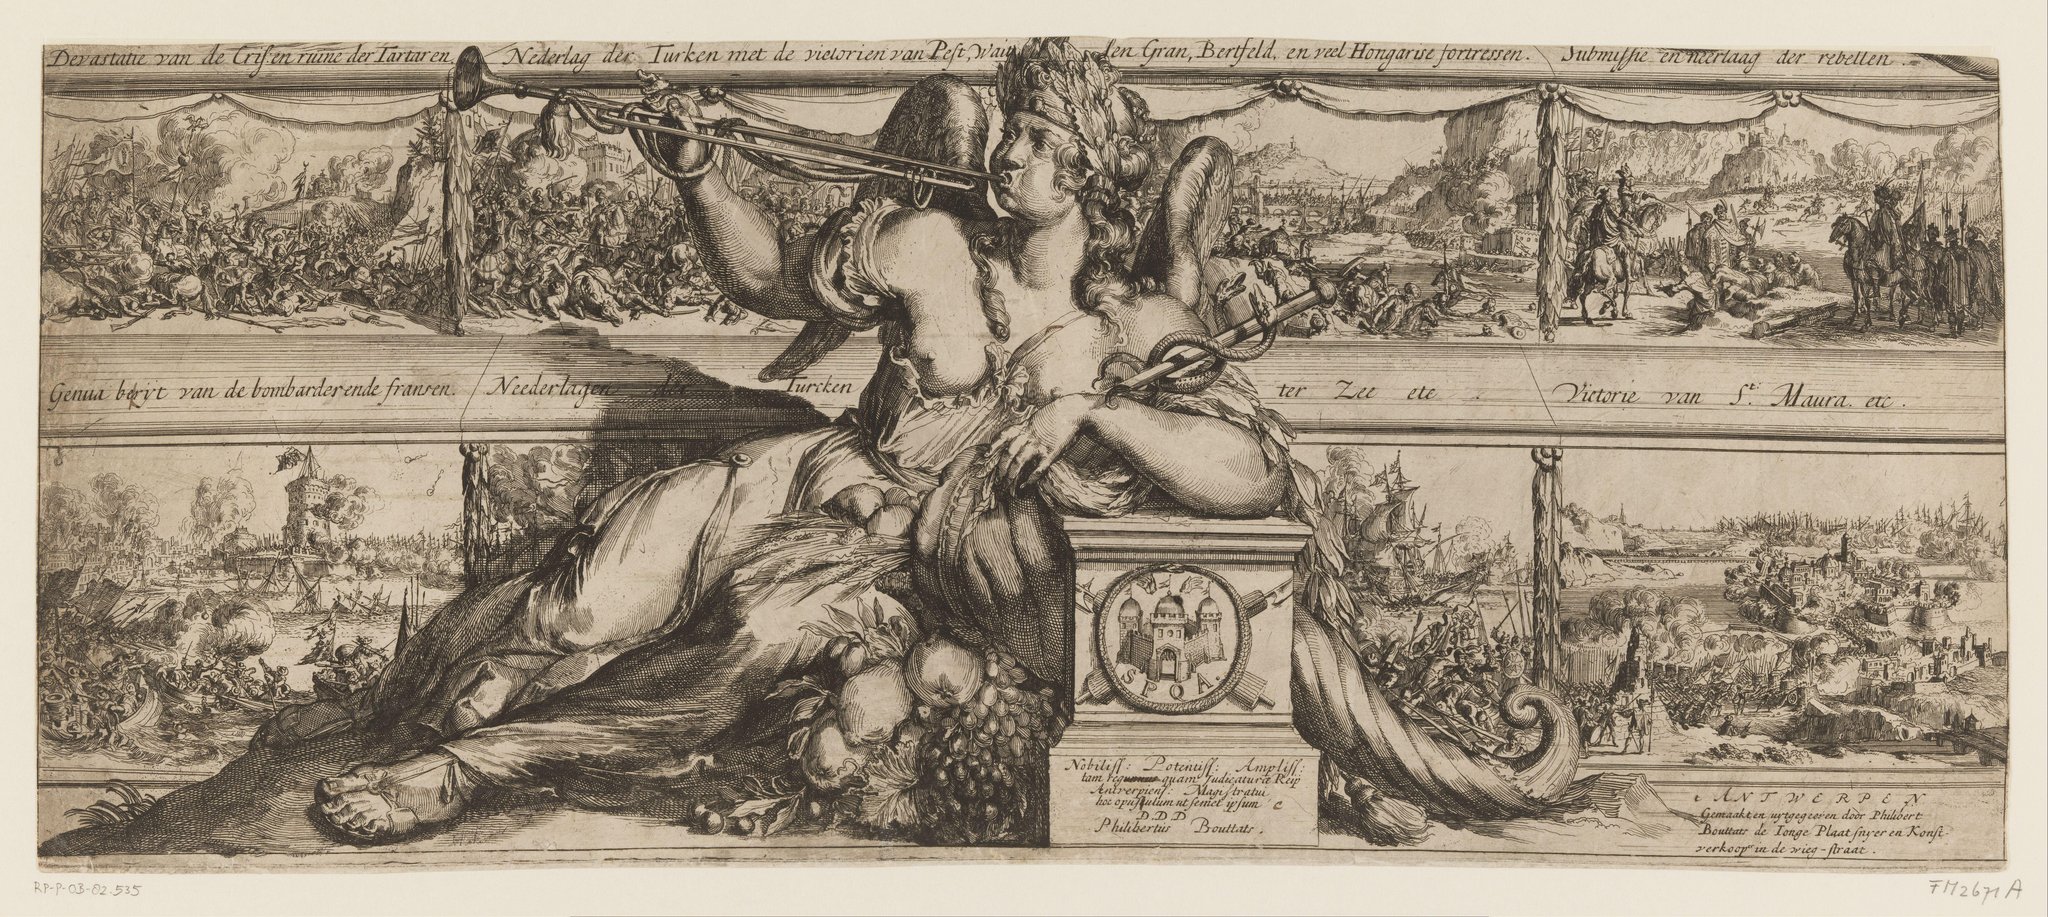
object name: print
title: Allegorie op de overwinningen op de Turken, 1685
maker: philibert bouttats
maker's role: print maker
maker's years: 1635-1708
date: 1685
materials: paper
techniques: etching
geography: antwerp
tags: fame; 'fama', 'fama buona', 'fama chiara' (ripa), battle (+ land forces)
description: Deze prent hier in de eerste staat met volledige figuur van de Faam en met naam en adres Philibert Bouttats. In een latere staat (zie de afbeelding in het artikel in Oud-Holland) is de plaat afgesneden waardoor alleen een buste van de Faam overblijft en gebruikt in een groter blad met de naam van Romeyn de Hooghe en adres Philibert Bouttats te Antwerpen.